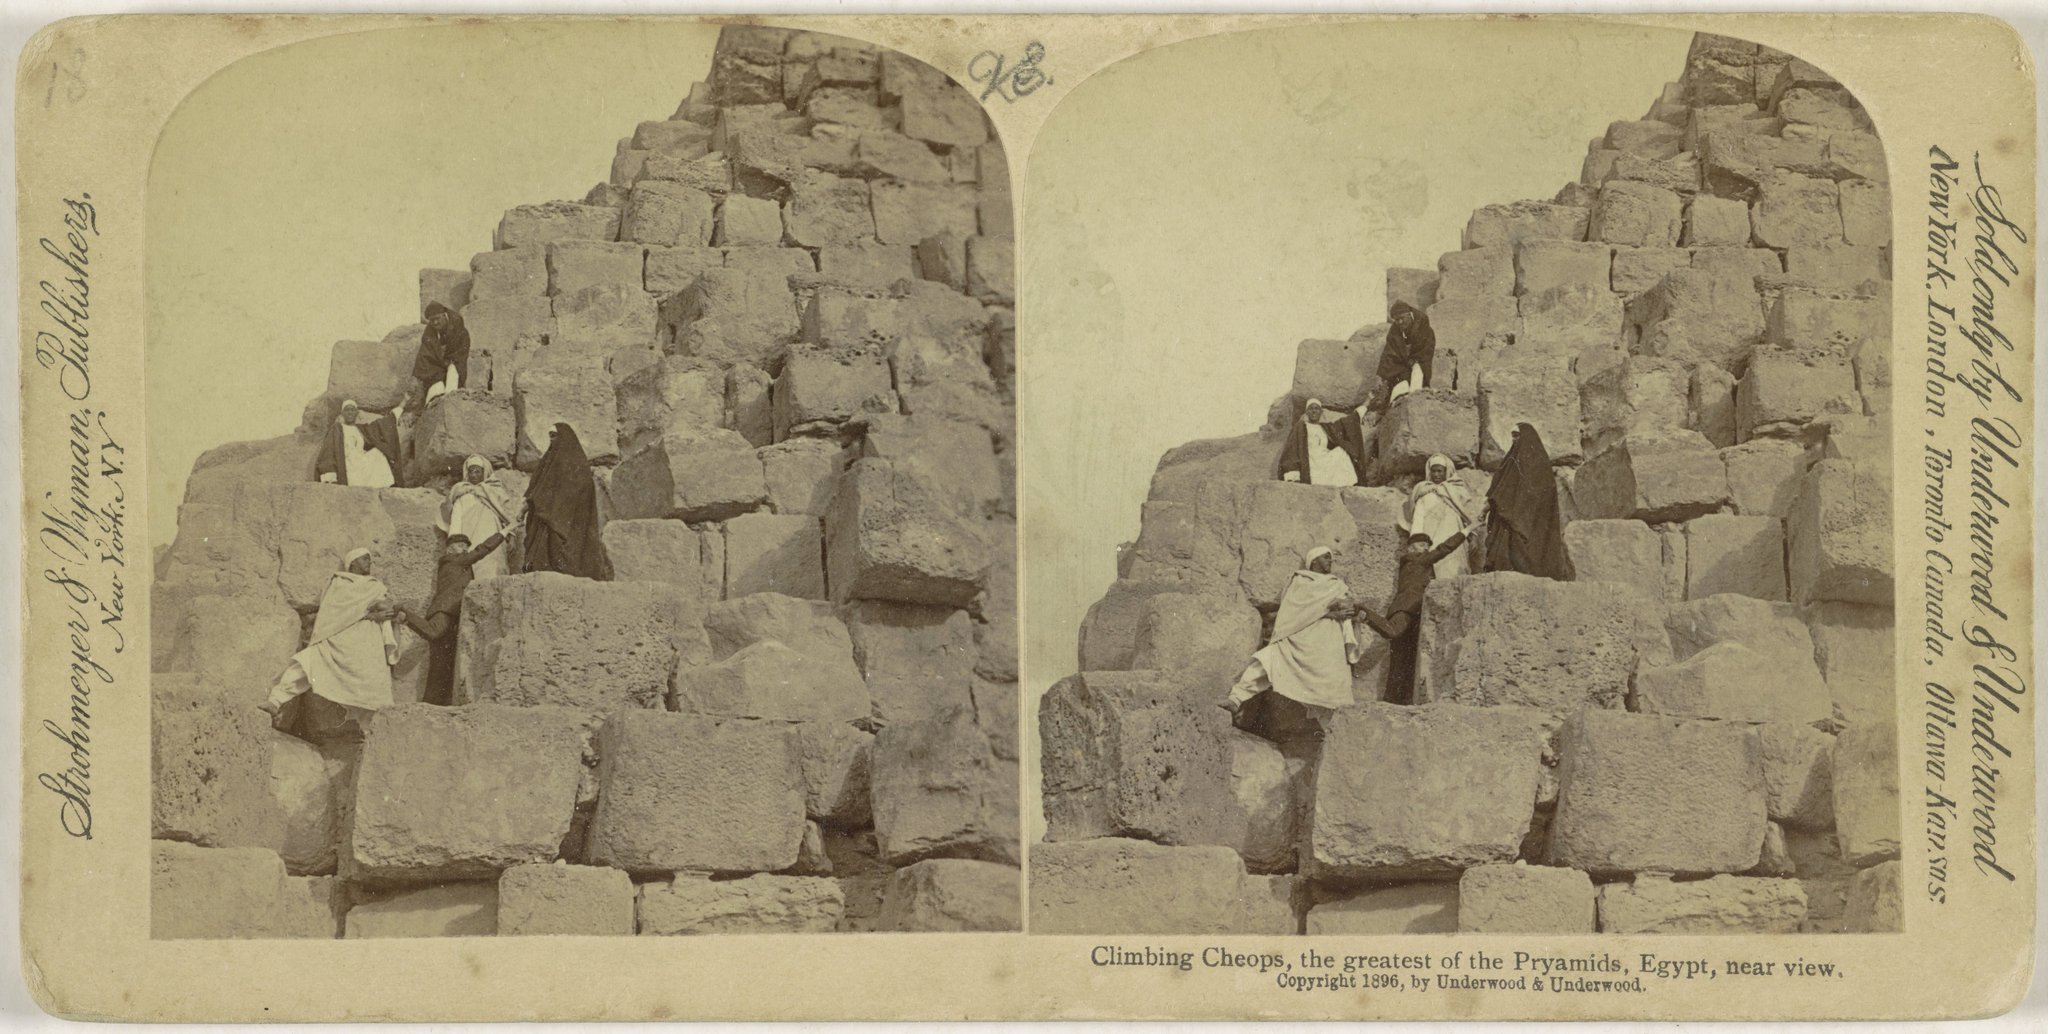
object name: stereograph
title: Climbing Cheops, the greatest of the Pyramids, Egypt, near view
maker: Anonymous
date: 1896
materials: cardboard, paper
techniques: albumen print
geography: new york city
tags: climbing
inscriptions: title: ‘Climbing Cheops, Greatest of the Pyramids, Egypt.’, copyright notice: ‘Copyright 1896, by Underwood & Underwood.’